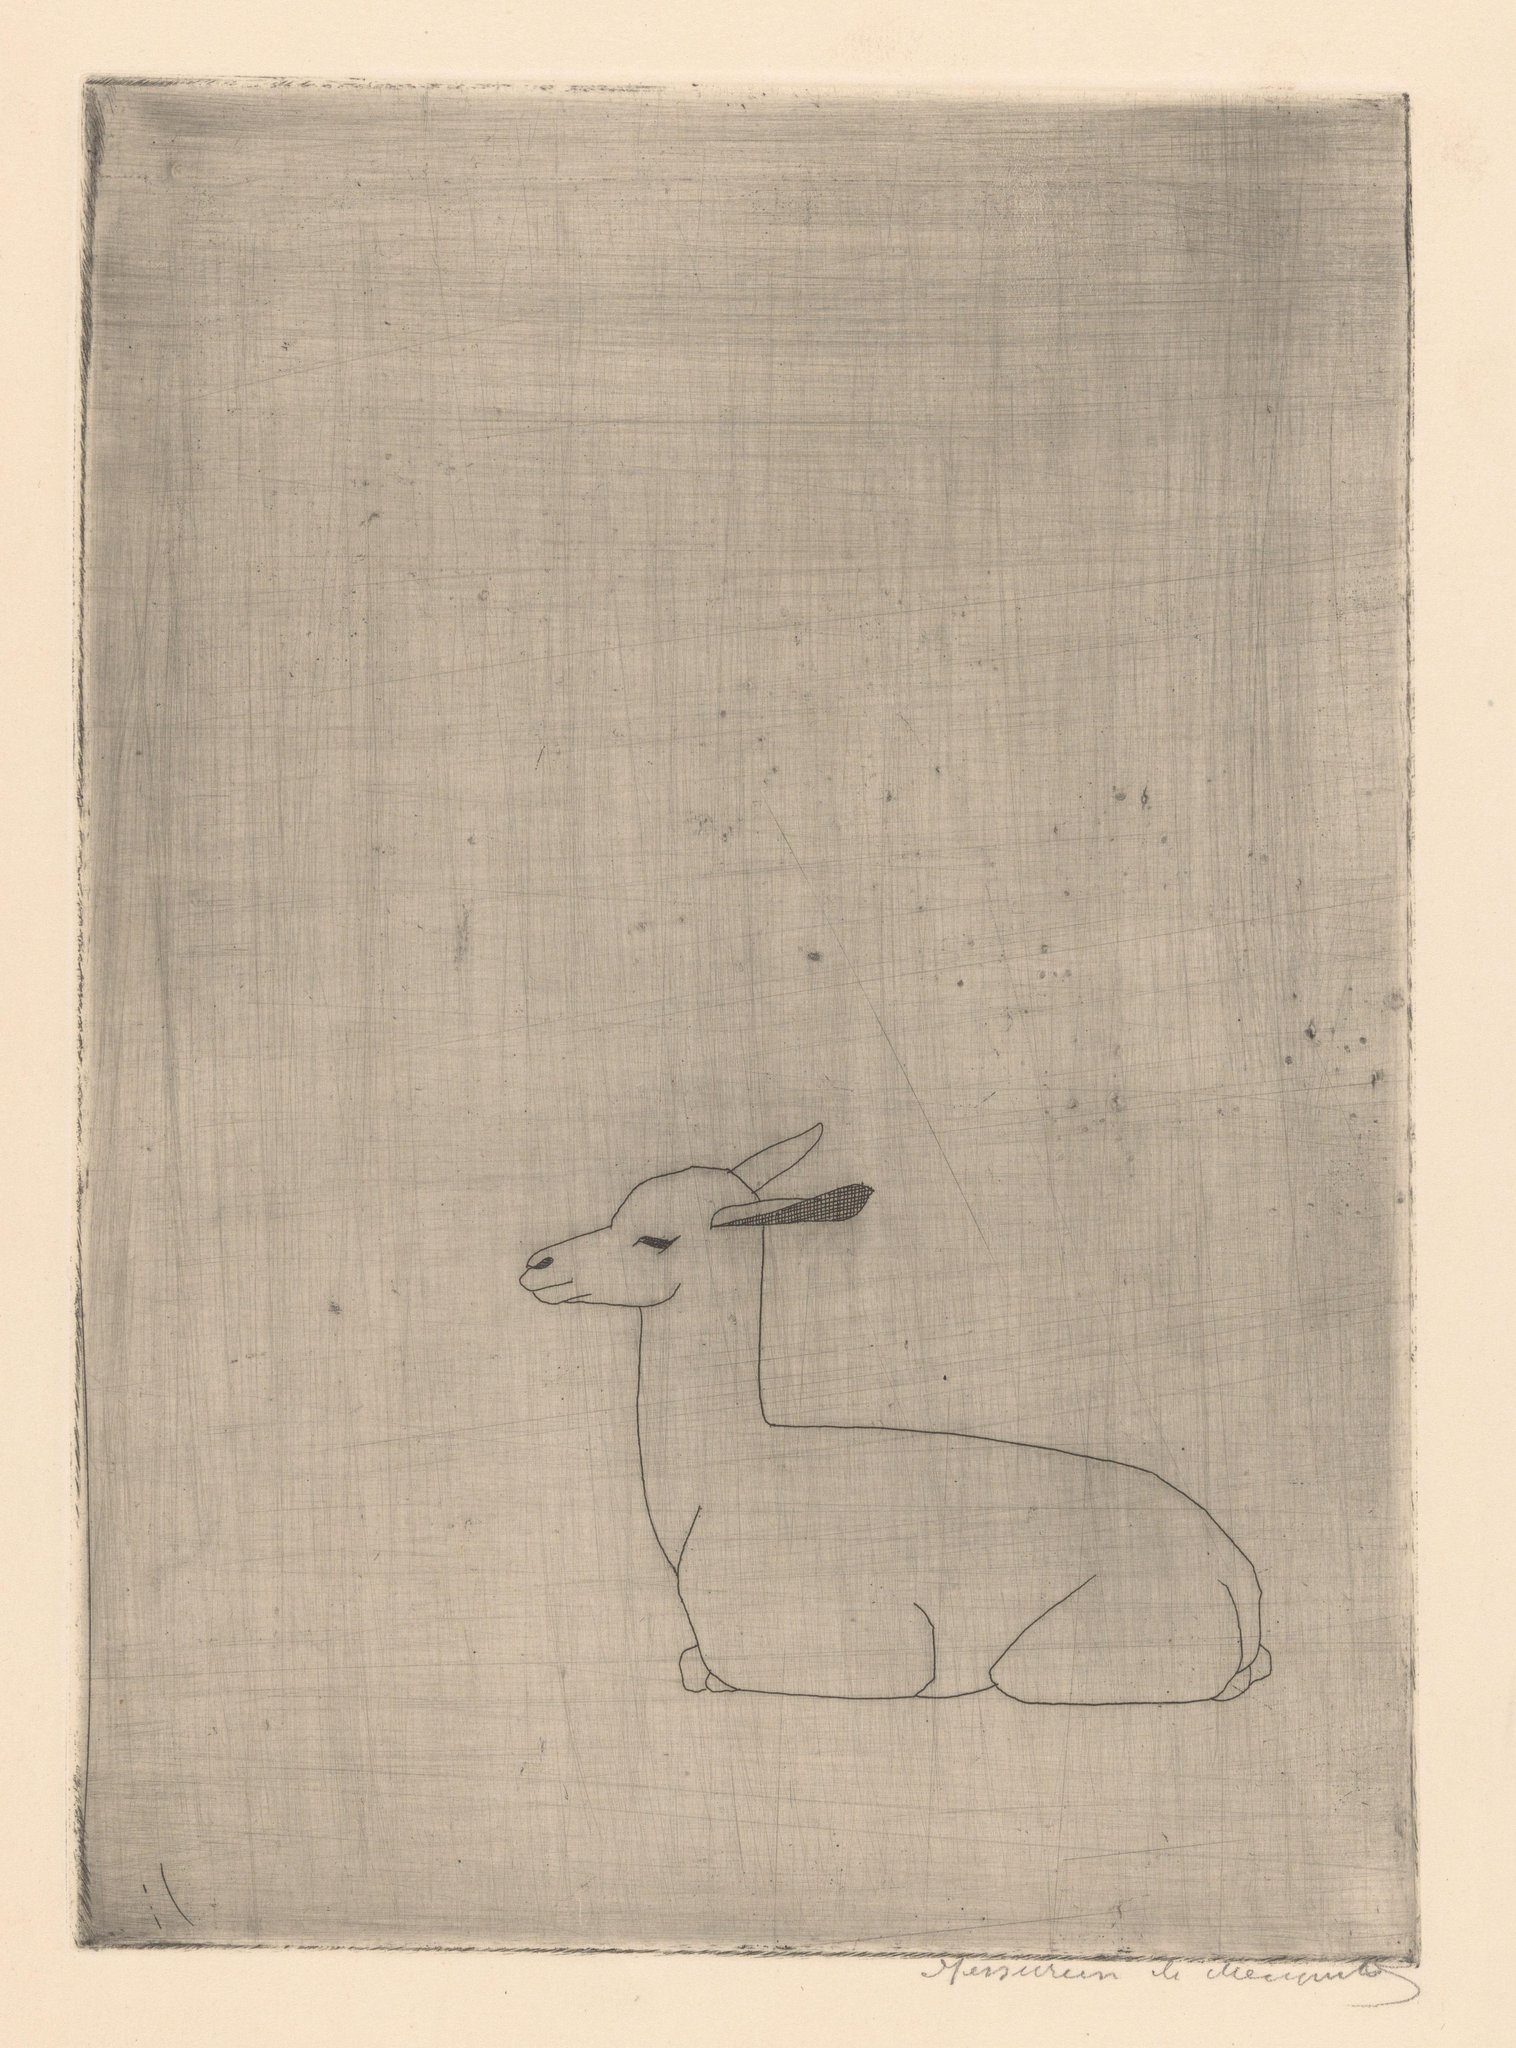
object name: print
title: Jonge lama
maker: samuel jessurun de mesquita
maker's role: draughtsman, print maker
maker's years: 1868-1944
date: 1930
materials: paper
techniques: etching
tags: pack-animal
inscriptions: collector's mark: Lugt 2228